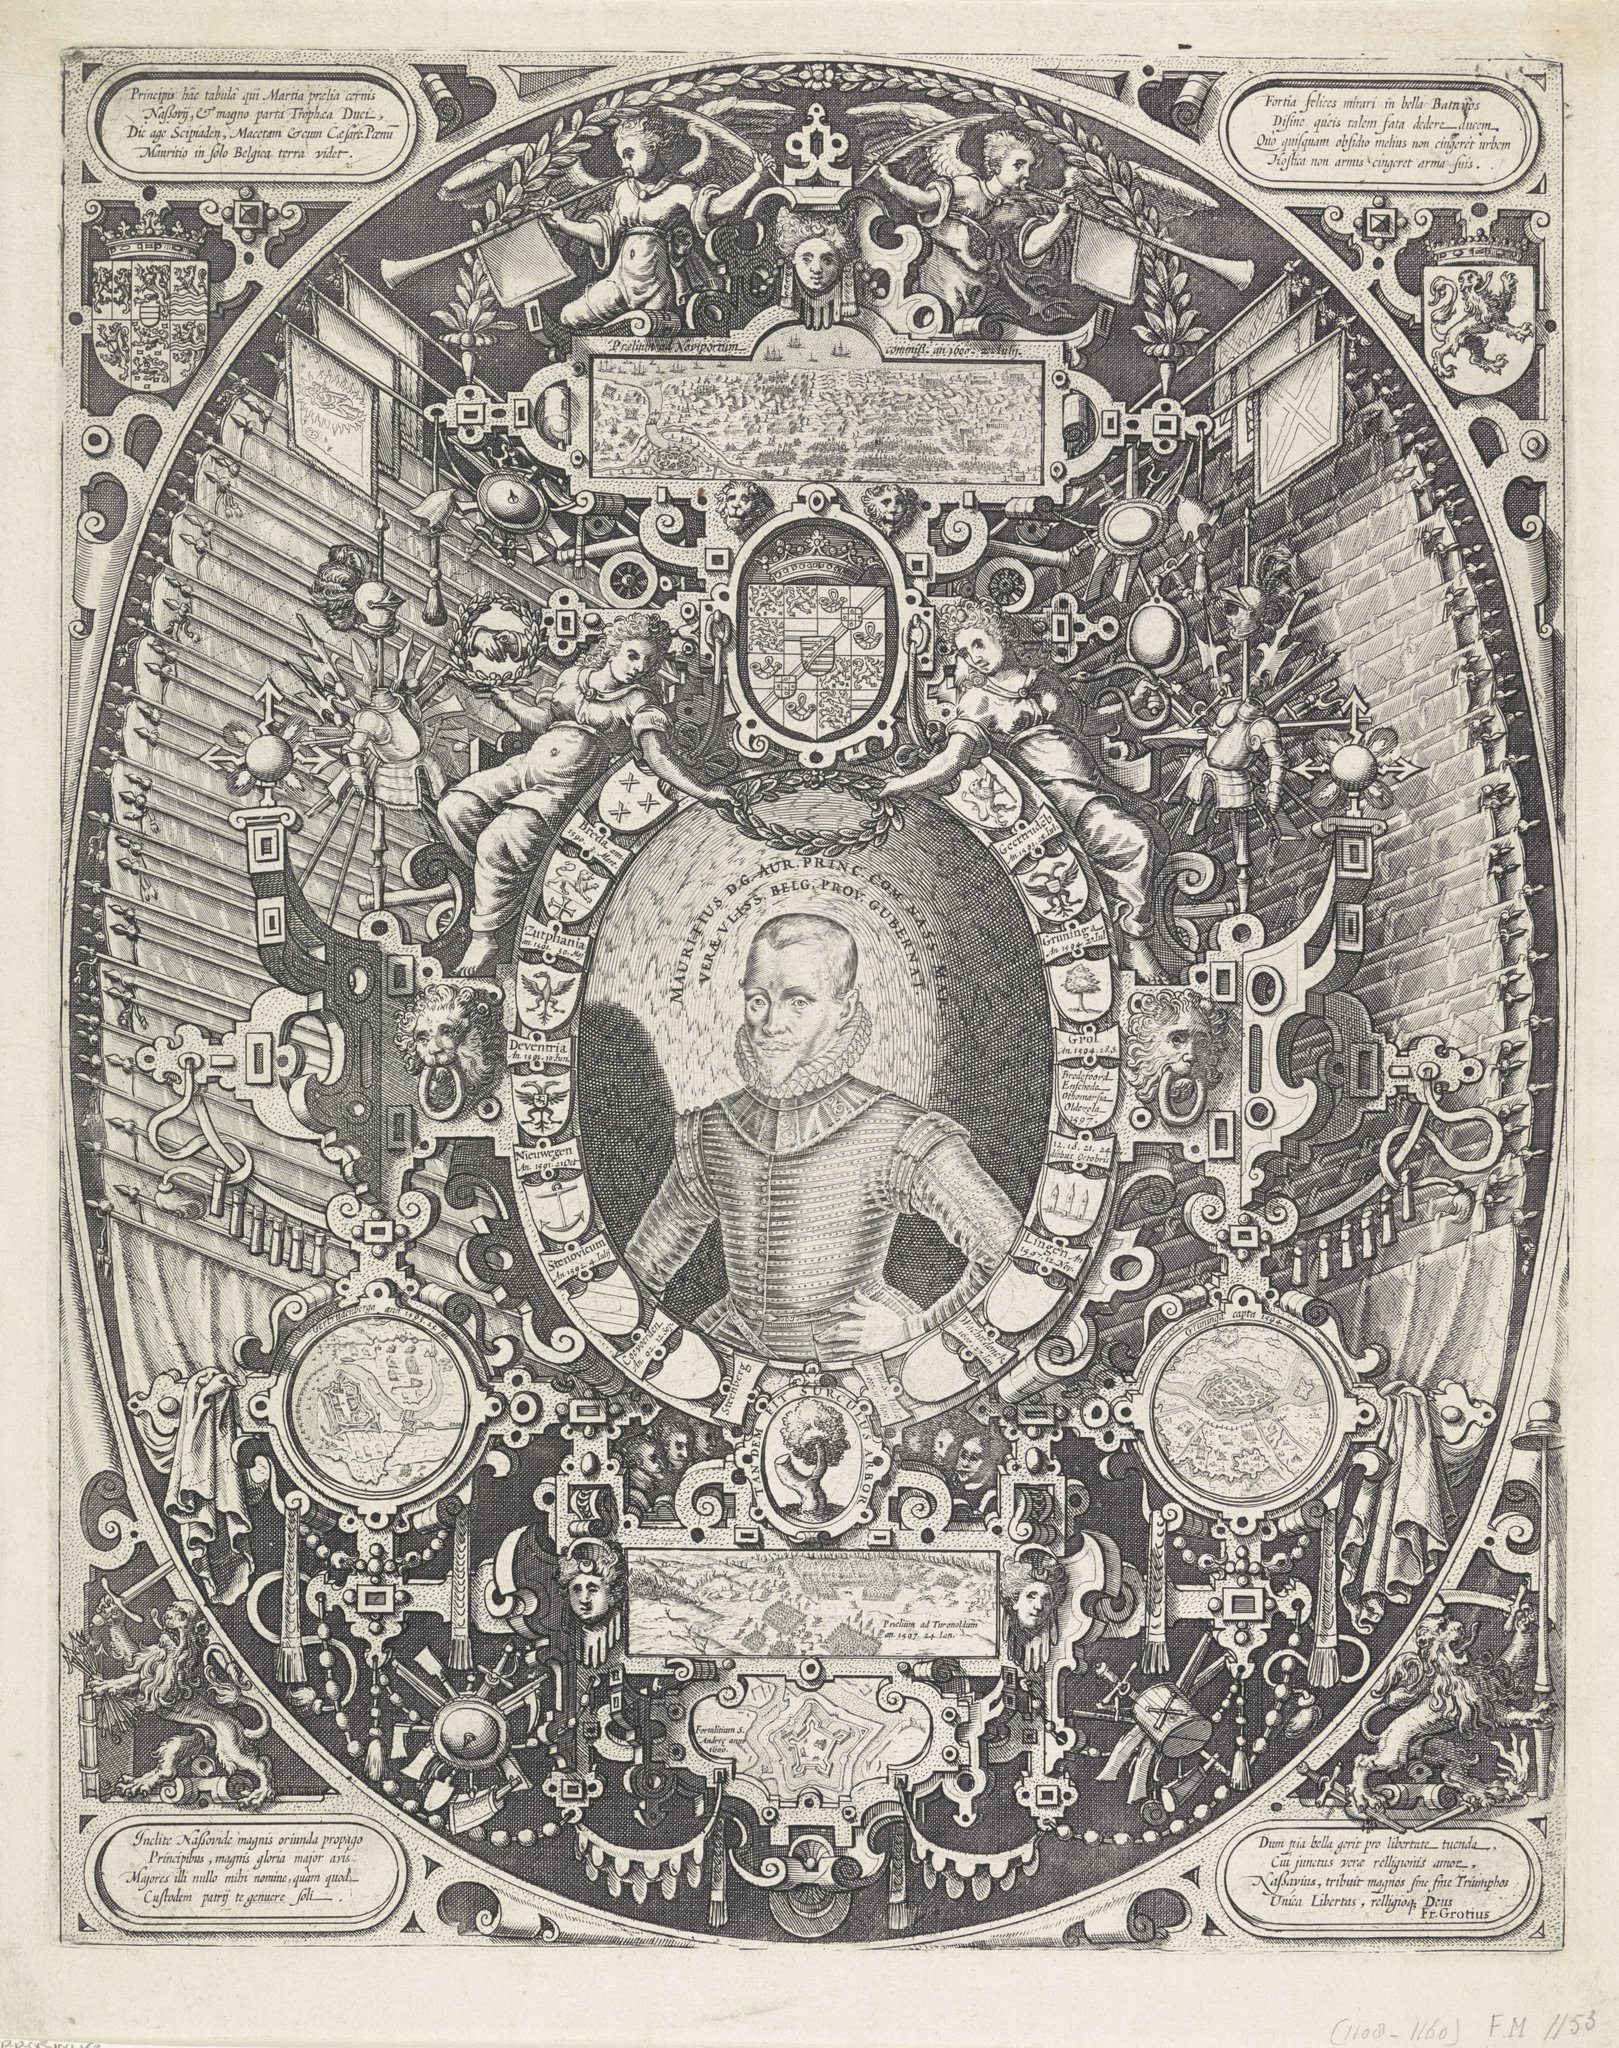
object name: print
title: Portret van Maurits, prins van Oranje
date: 1600-1602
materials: paper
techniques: engraving, etching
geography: northern netherlands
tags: the hague, maurice (prince of orange), battle of nieuwpoort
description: Portret van Maurits in een ovaal gevormd door wapens van veroverde plaatsen. Eendracht en Voorzichtigheid houden een lauwerkrans boven zijn hoofd. In vijf kleine scènes de veroveringen te Geertruidenberg (1593), Groningen (1594), Turnhout (1597), Sint-Andries (1600) en Nieuwpoort (1600). Verder rolwerk, wapentrofeeën en de buitgemaakte Spaanse vaandels. Onderaan links en rechts de Hollandse leeuw met links een pijlenbundel en rechts een zwaard en lans met vrijheidshoed. Verder ook de wapens van de prins en van de Staten-Generaal. In de vier hoeken vier regels Latijnse tekst.